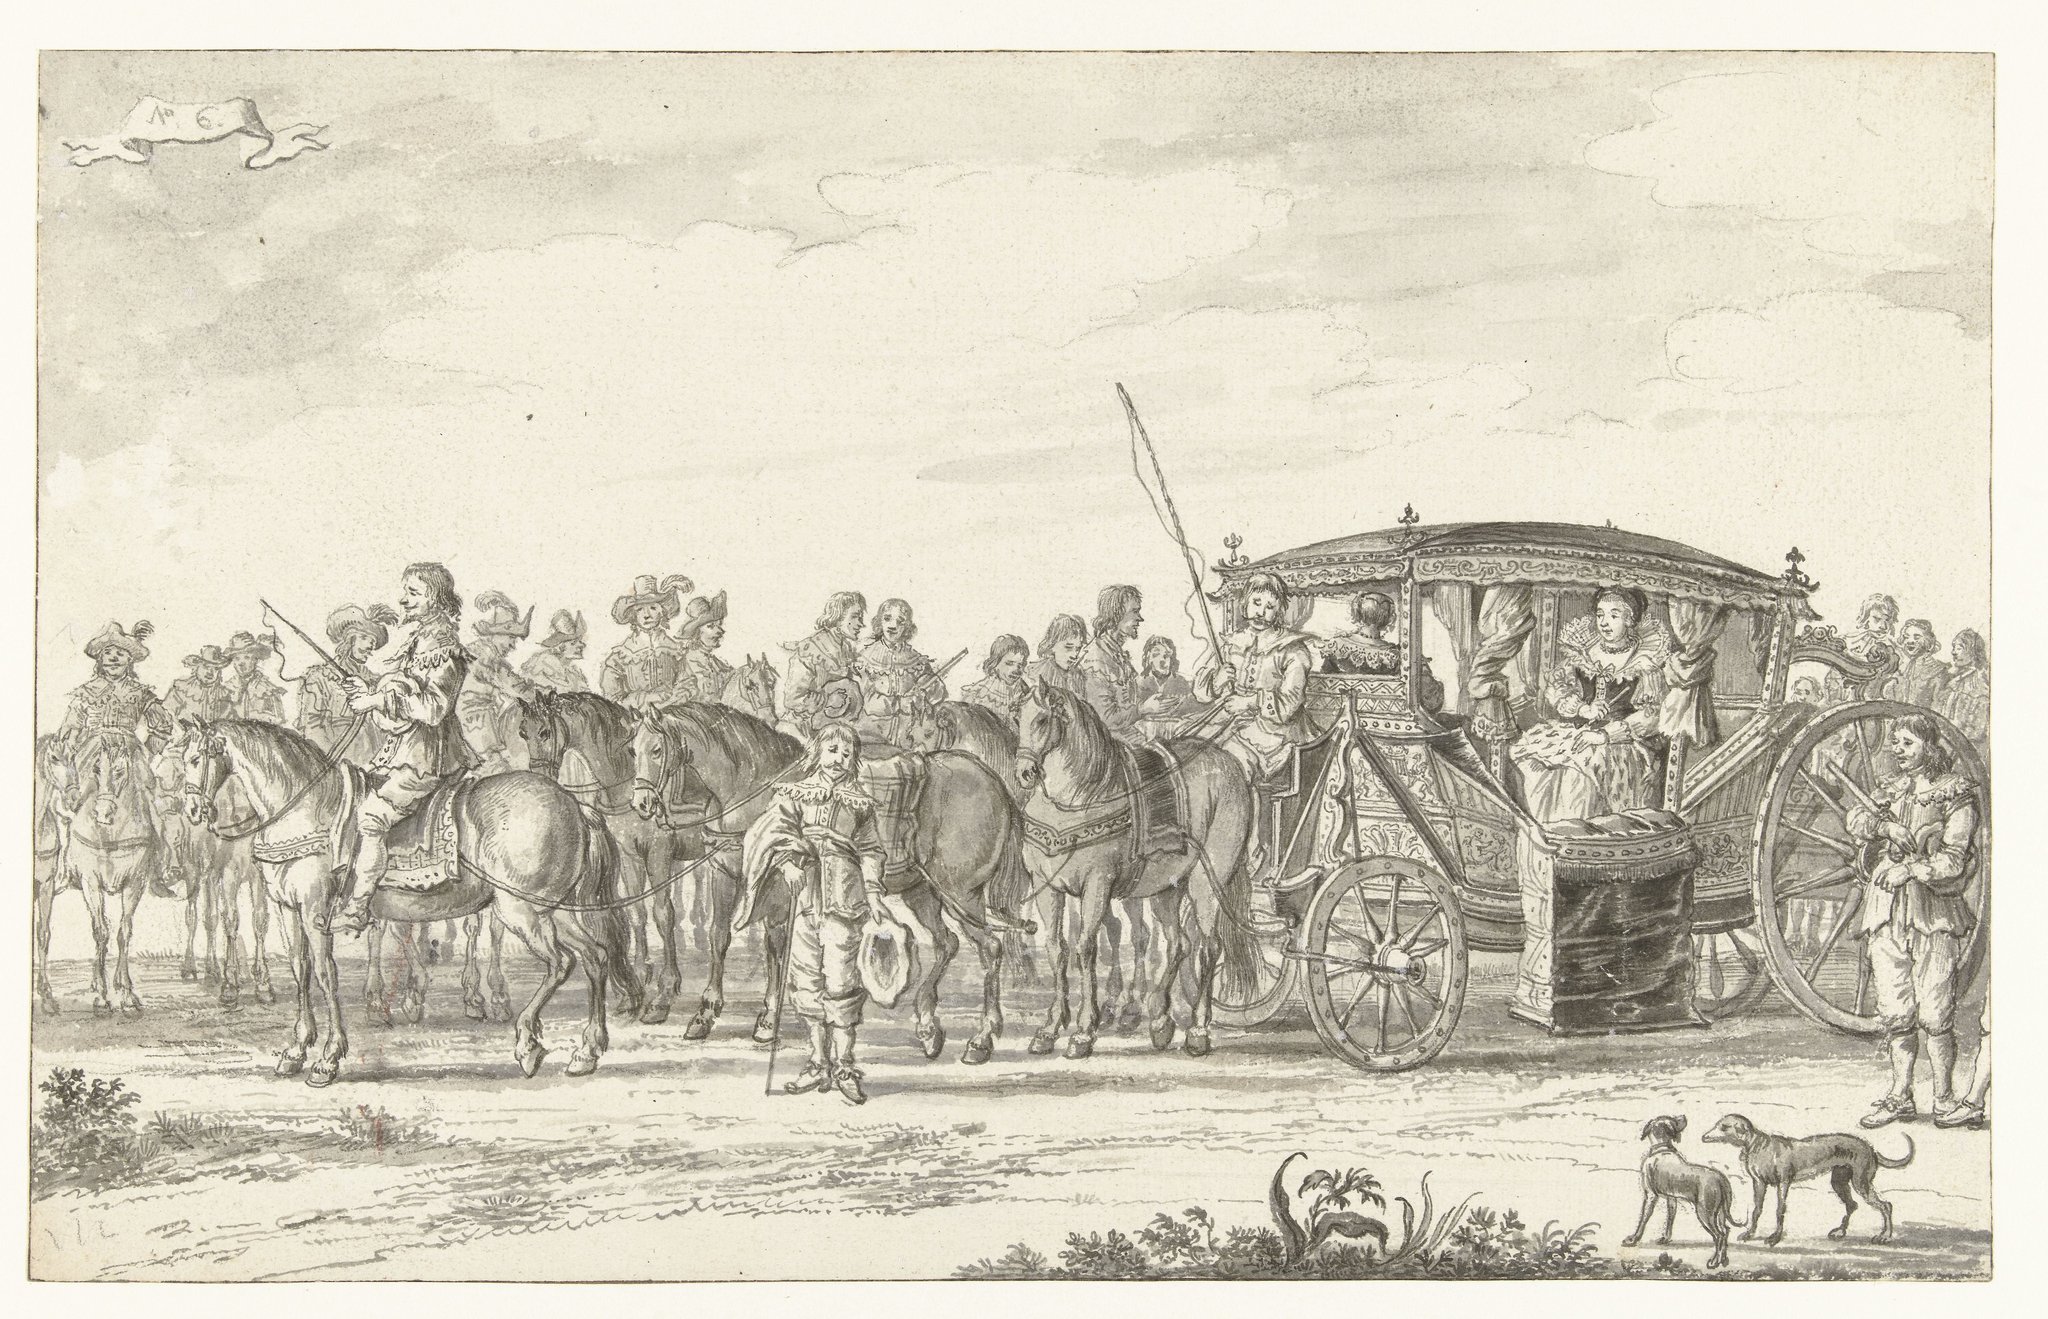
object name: design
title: Marie de'Medici's Entry into Amsterdam in 1638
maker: jan martszen de jonge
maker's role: draughtsman, painter, print maker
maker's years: 1609-1647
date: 1638-1639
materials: chalk, ink, paper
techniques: brush, pen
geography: northern netherlands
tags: the hague, amalia of solms-braunfels, cologne, print maker, maria de' medici, land forces (+ cavalry, horsemen), triumphal entry and public reception, pageant, 'entrée solennelle', 'joyeuse entrée', four-wheeled vehicle drawn by more than three animals, amsterdam